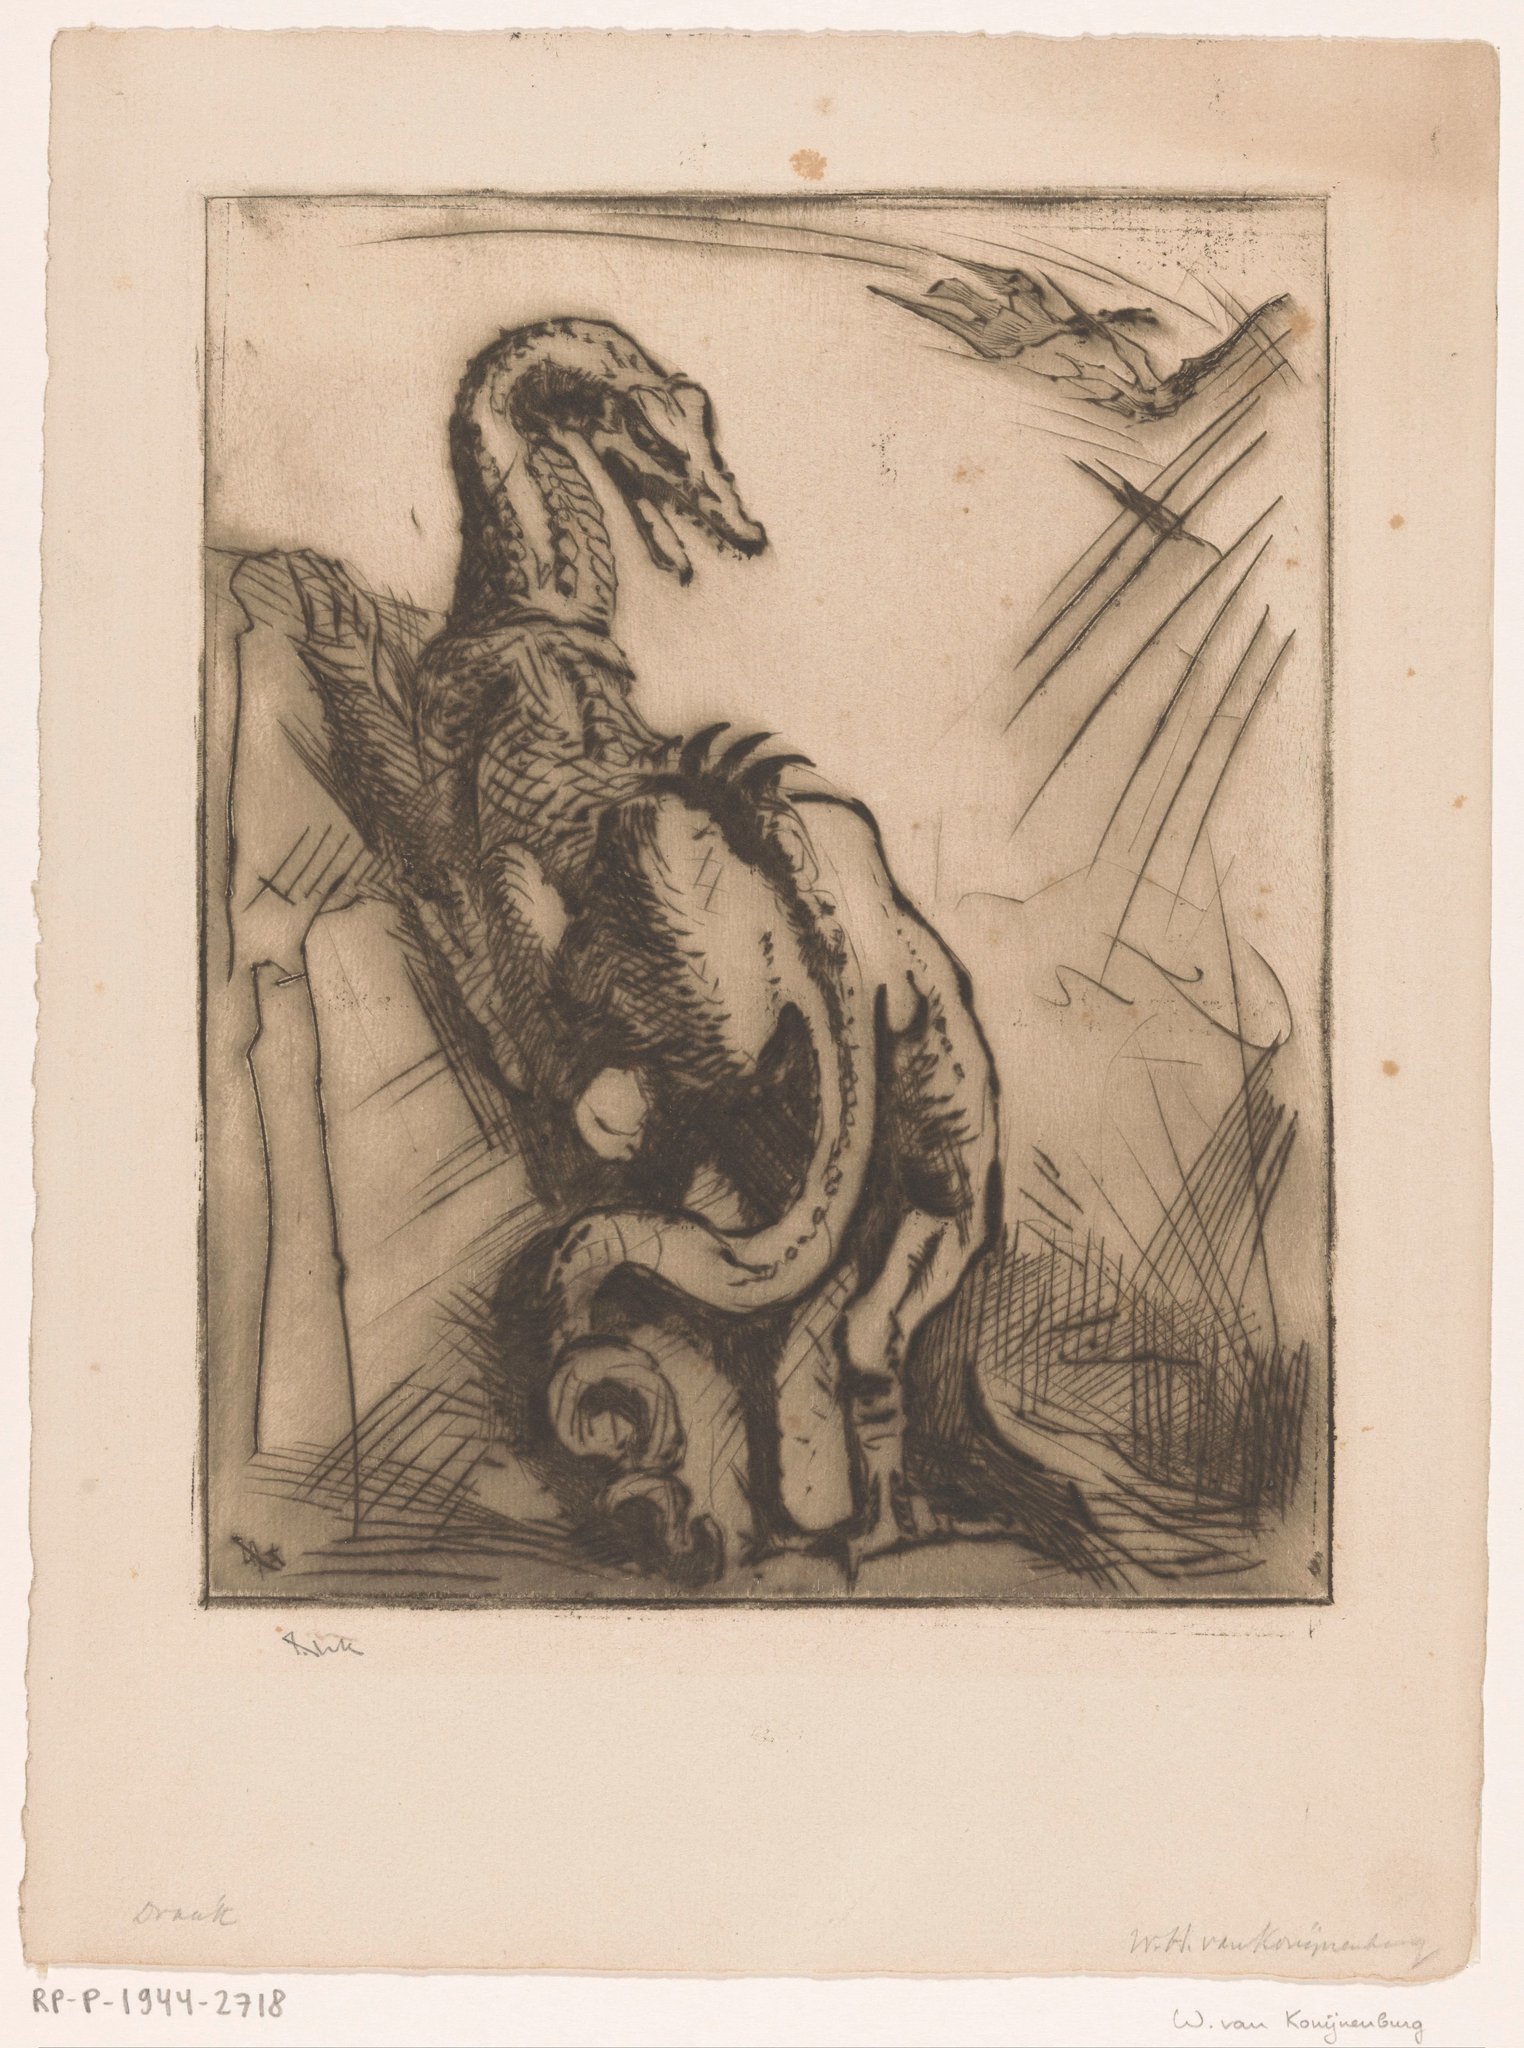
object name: print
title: Draak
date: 1878-1943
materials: paper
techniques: drypoint, intaglio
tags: dragon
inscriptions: collector's mark: Lugt 2228, collector's mark: Lugt 2760